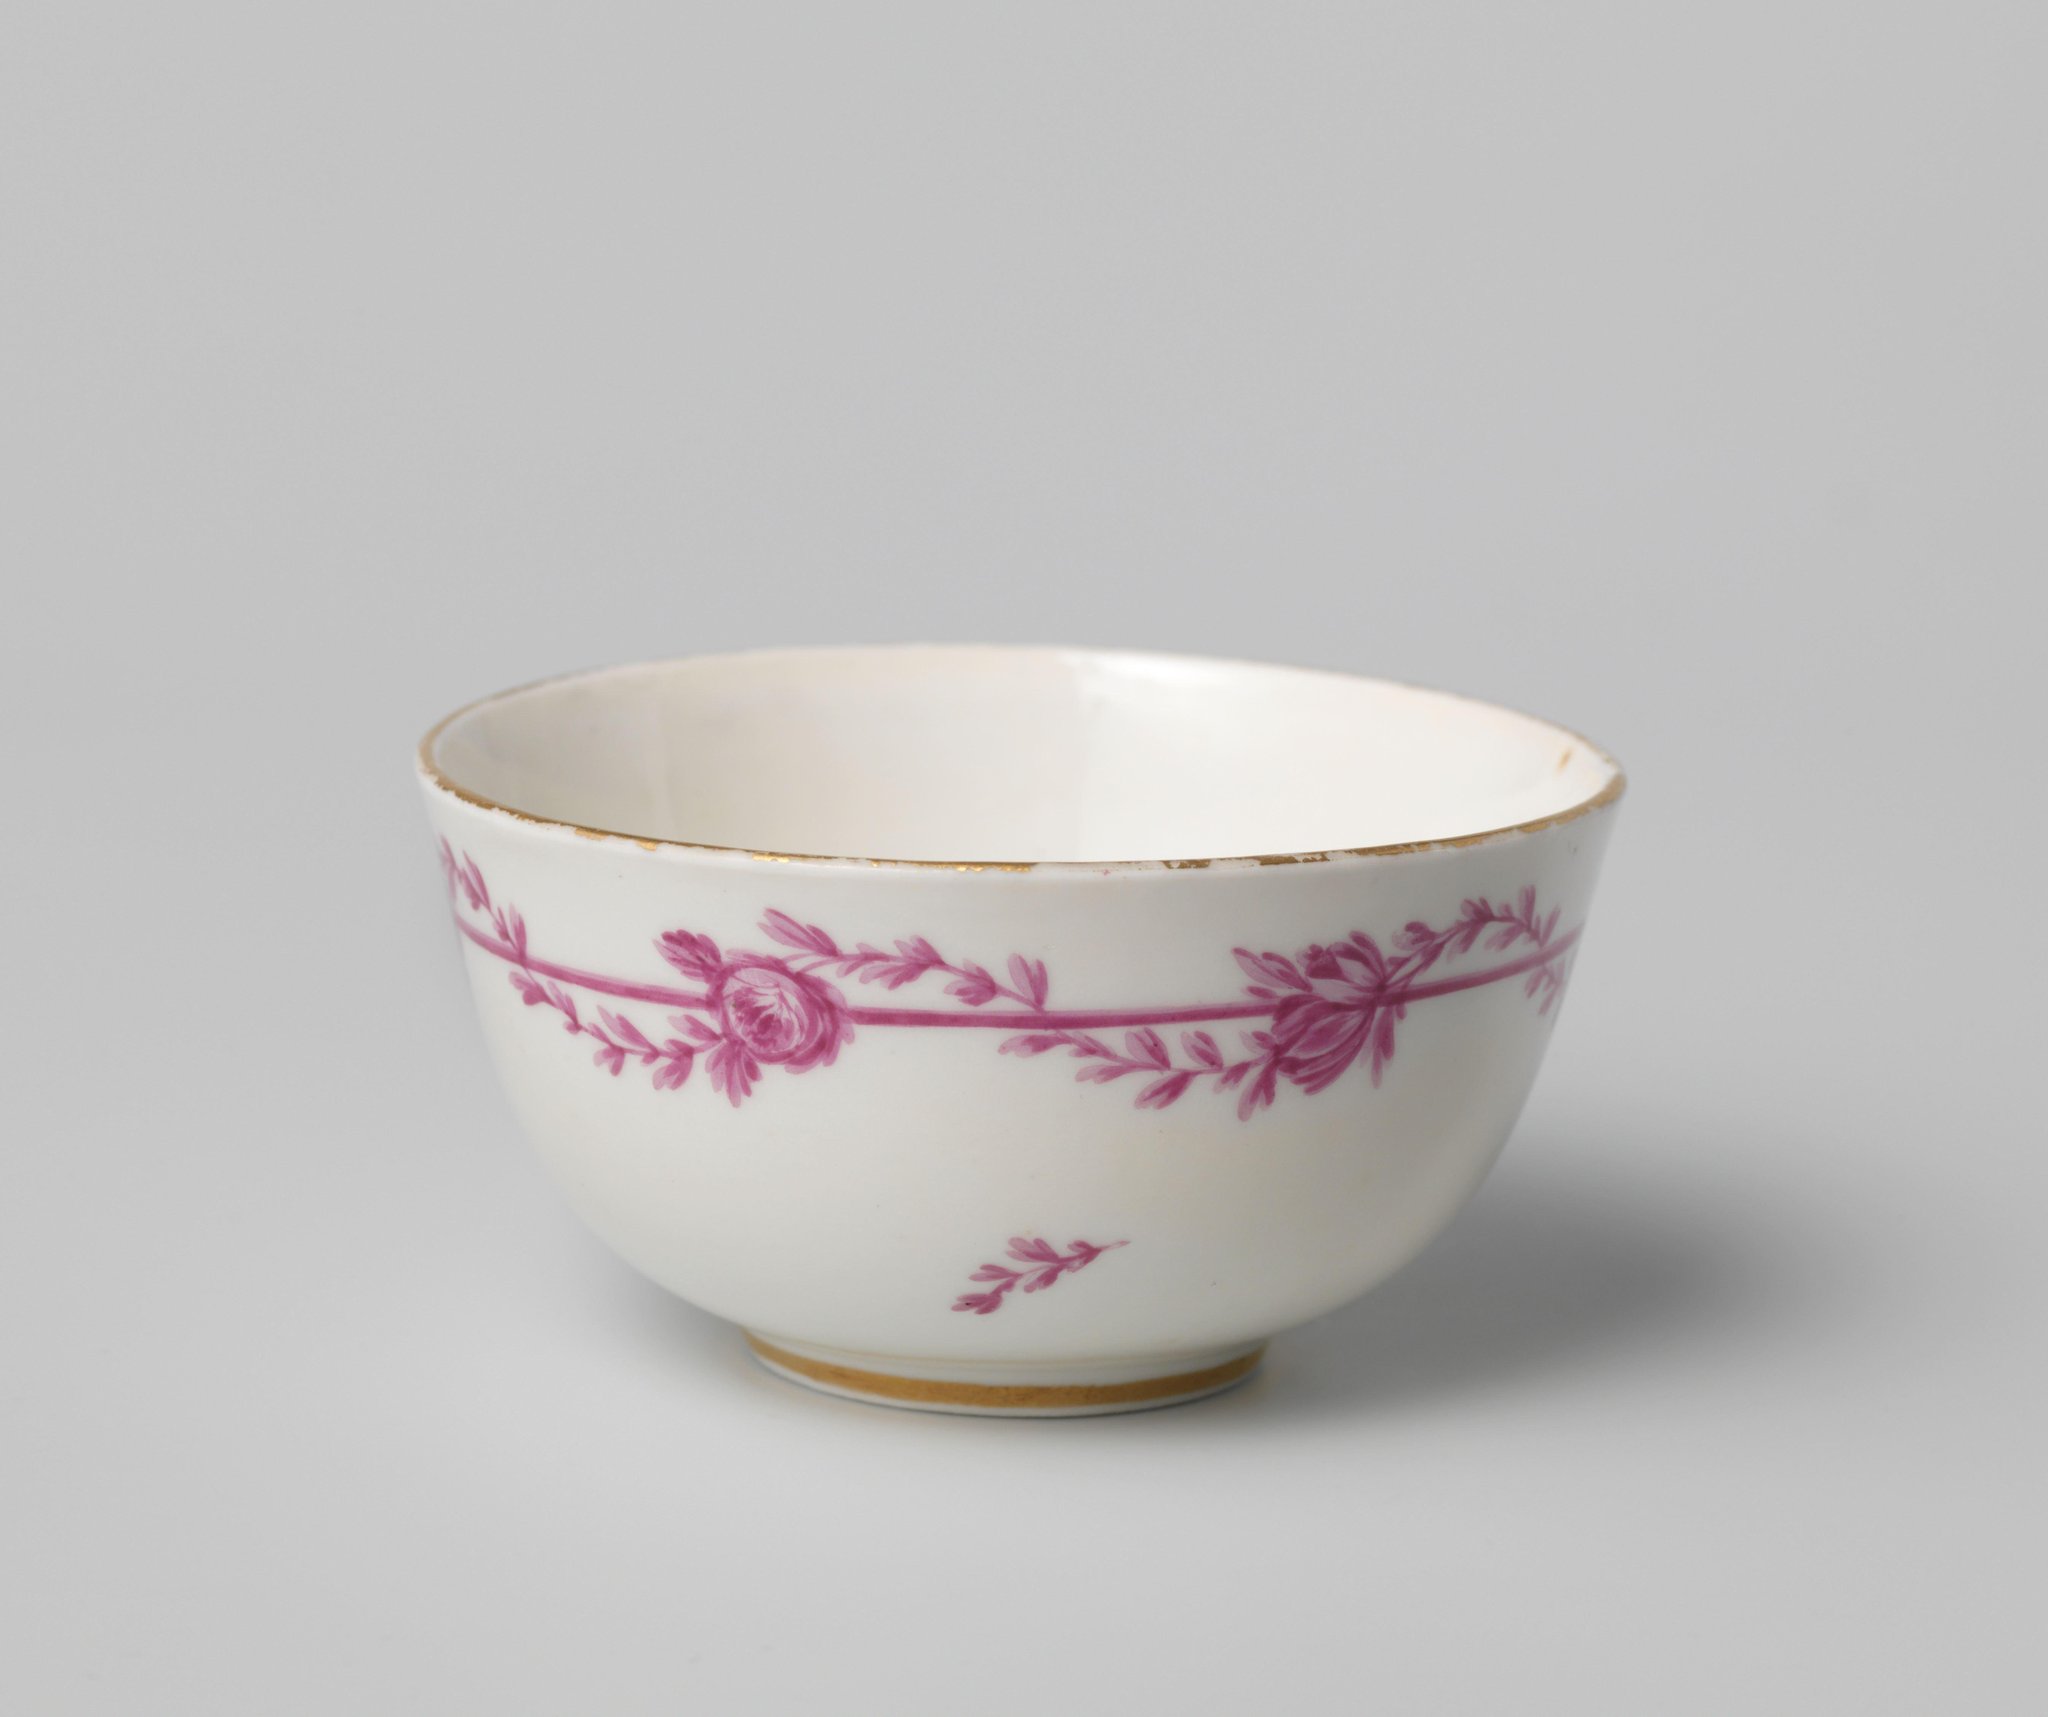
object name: kop en schotel, kop en schotel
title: Kop zonder oor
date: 1780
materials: porcelain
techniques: painted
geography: loosdrecht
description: Kop van porselein, versierd in bietenrood met een om een doorlopende bies geslingerde bloem- en bladslinger. De randen zijn verguld. Versierd met strooibloempjes in bietenrood. Gemerkt M.O.L. met ster in onderglazuurblauw.